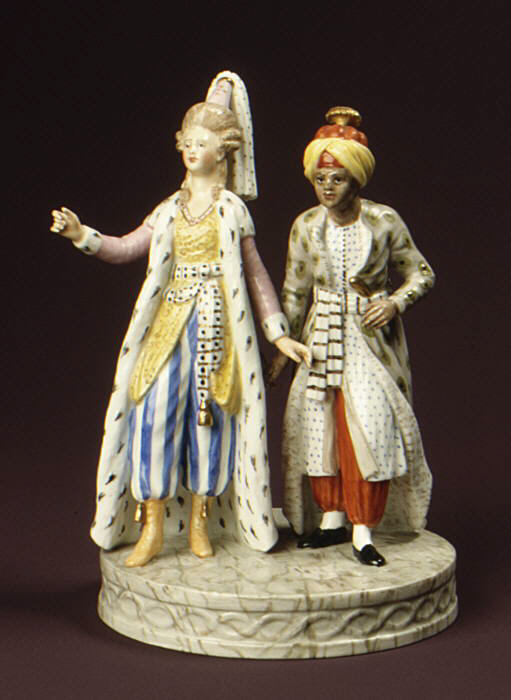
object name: group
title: Sultana and Attendant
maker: royal porcelain manufactory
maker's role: factory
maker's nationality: danish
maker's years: 1775-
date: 1830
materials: hard paste porcelain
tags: men,women